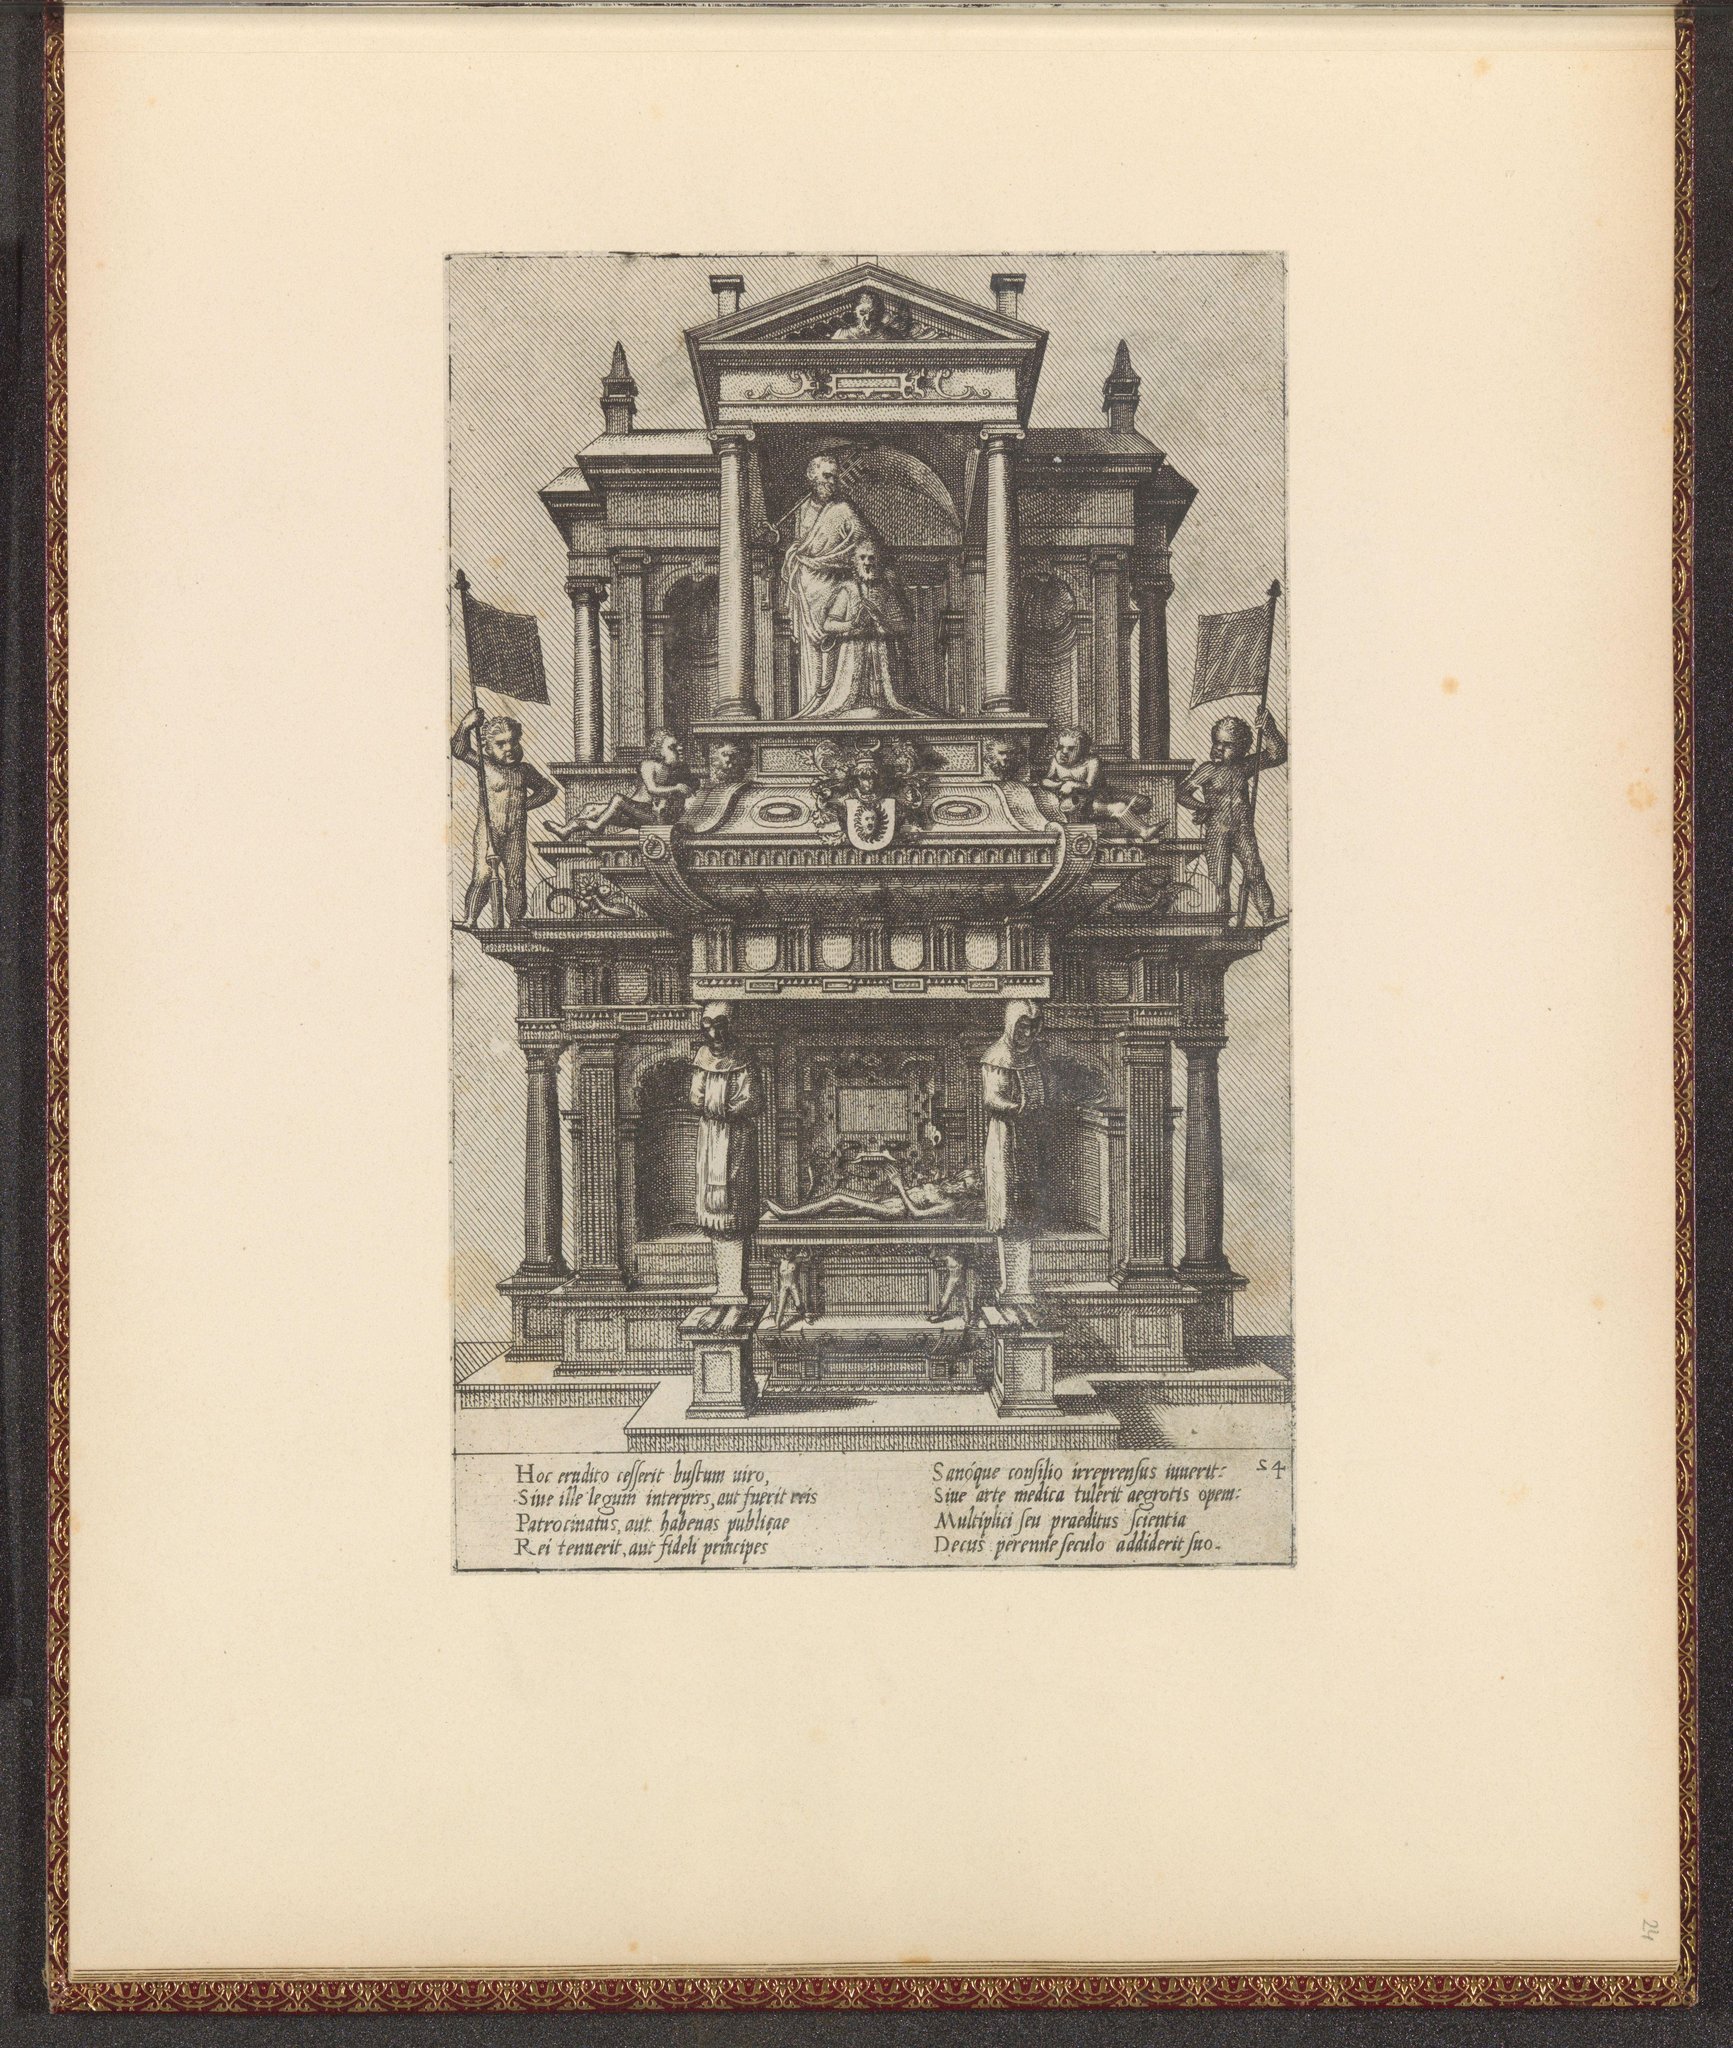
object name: album leaf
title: Architectonisch grafmonument met Petrus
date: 1563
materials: paper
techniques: etching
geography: antwerp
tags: effigies portraying half-decayed state, kneeling figure, grave-building, monumental tomb, grave, tomb and other grave-forms and grave-markers, the apostle peter, first bishop of rome; possible attributes: book, cock, (upturned) cross, (triple) crozier, fish, key, scroll, ship, tiara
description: Architectonisch grafmonument bedoeld om tegen een muur te worden geplaatst. Het monument heeft een tweeledige opbouw met een vooruitspringend middenrisaliet. Onderaan de beeltenis van de overledene in vergane toestand, tussen twee hermen in de vorm van monniken. Bovenaan een knielende man geflankeerd door Petrus als zijn patroonheilige. In de ondermarge acht regels tekst, in twee kolommen, in het Latijn. De prent maakt deel uit van een album.